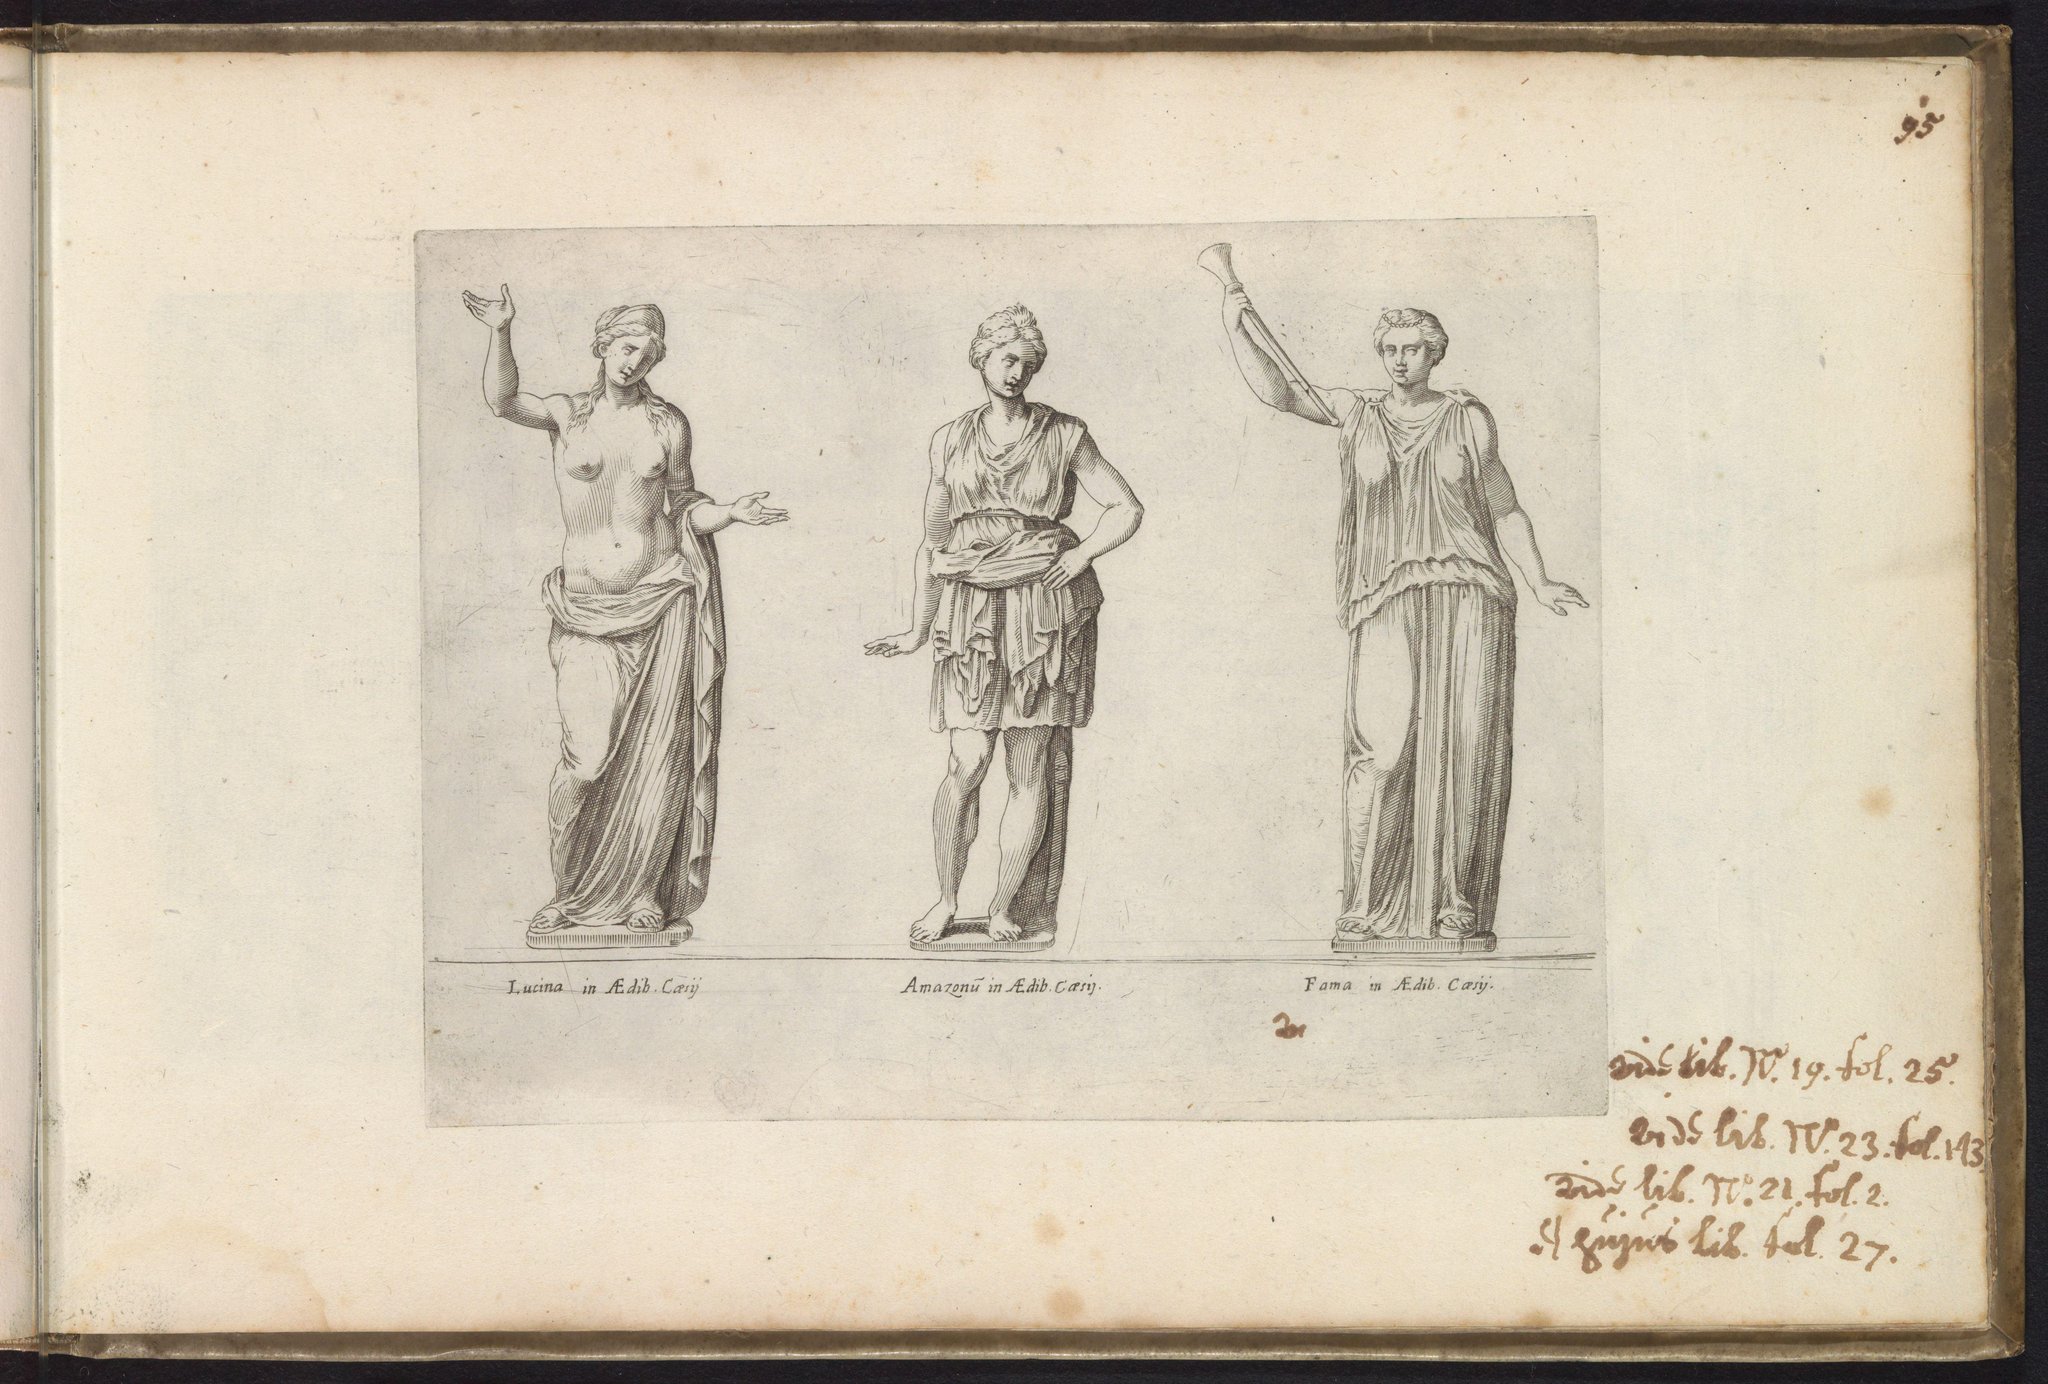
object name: album leaf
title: Sculpturen uit de oudheid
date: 1538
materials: paper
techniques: engraving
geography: rome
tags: (story of) the amazons, lucina, piece of sculpture, reproduction of a piece of sculpture, fame; 'fama', 'fama buona', 'fama chiara' (ripa)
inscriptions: number: ‘95’, inscription: ‘Ende lib. No. 19. fol. 25./ Ende lib. No. 23. fol. 143./ Ende lib. No. 21. fol. 2./ [...] lib. fol. 27.’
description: Deze prent maakt deel uit van een reeks van ten minste 19 prenten van sculpturen uit de oudheid.